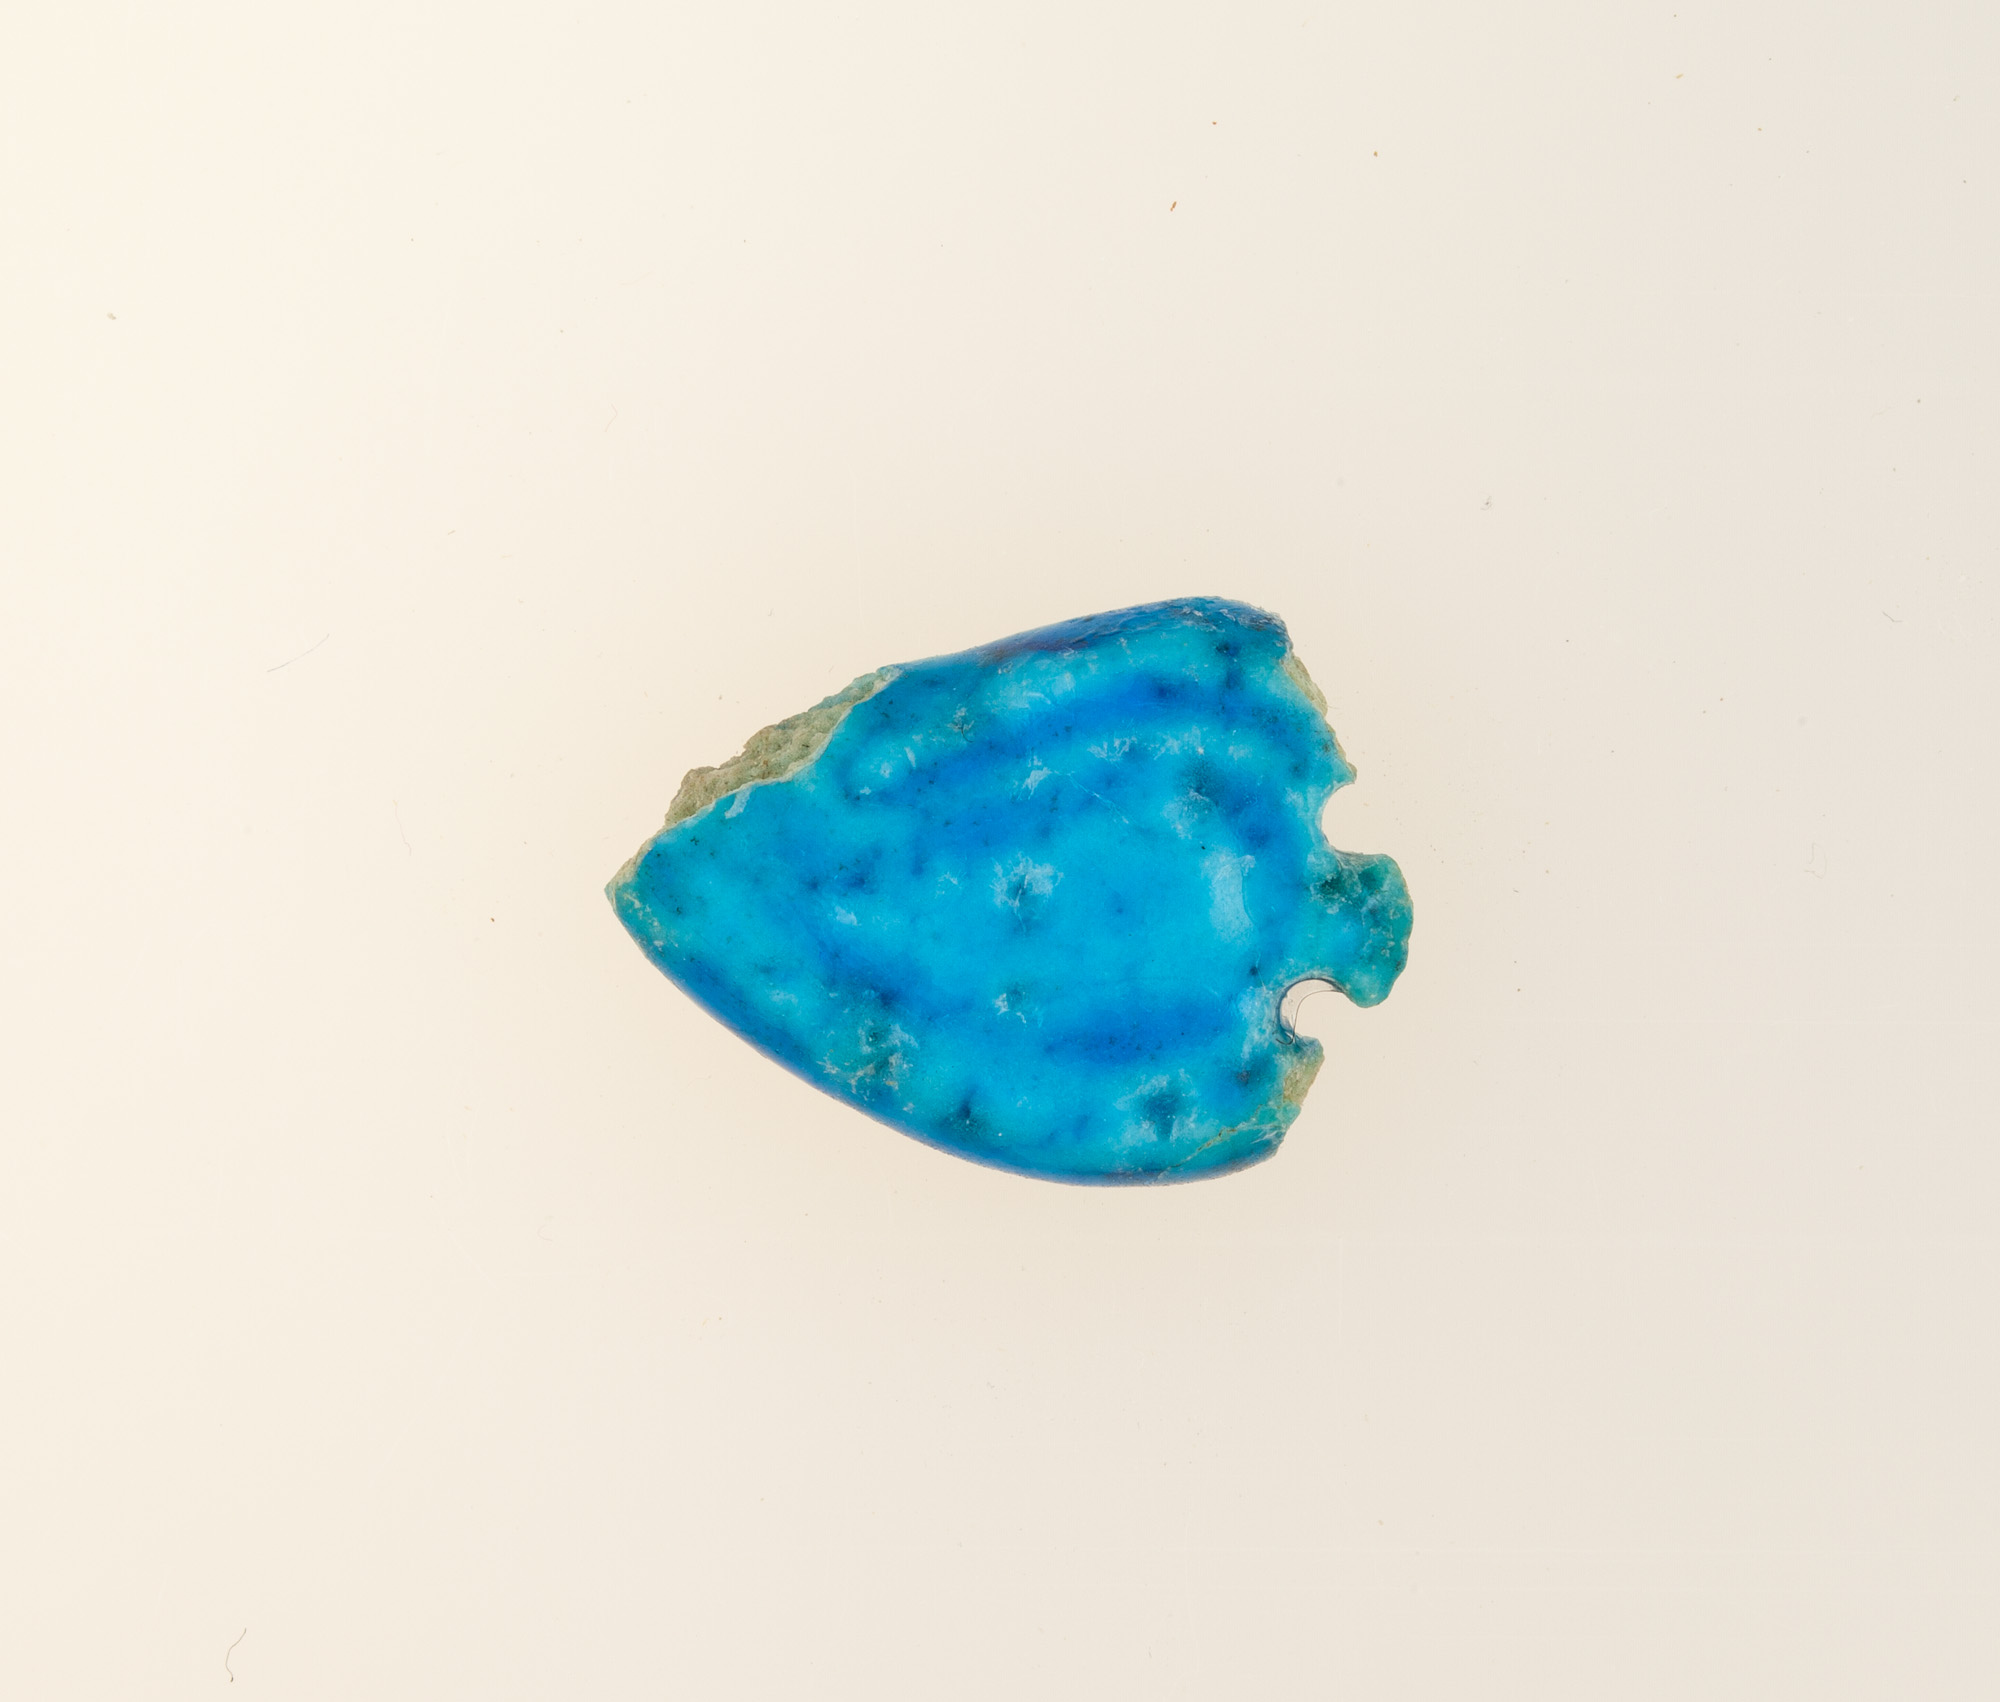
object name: pendant fragment, leaf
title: Votive Fragment, Pendant fragment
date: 1479-1458 BCE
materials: faience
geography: egypt